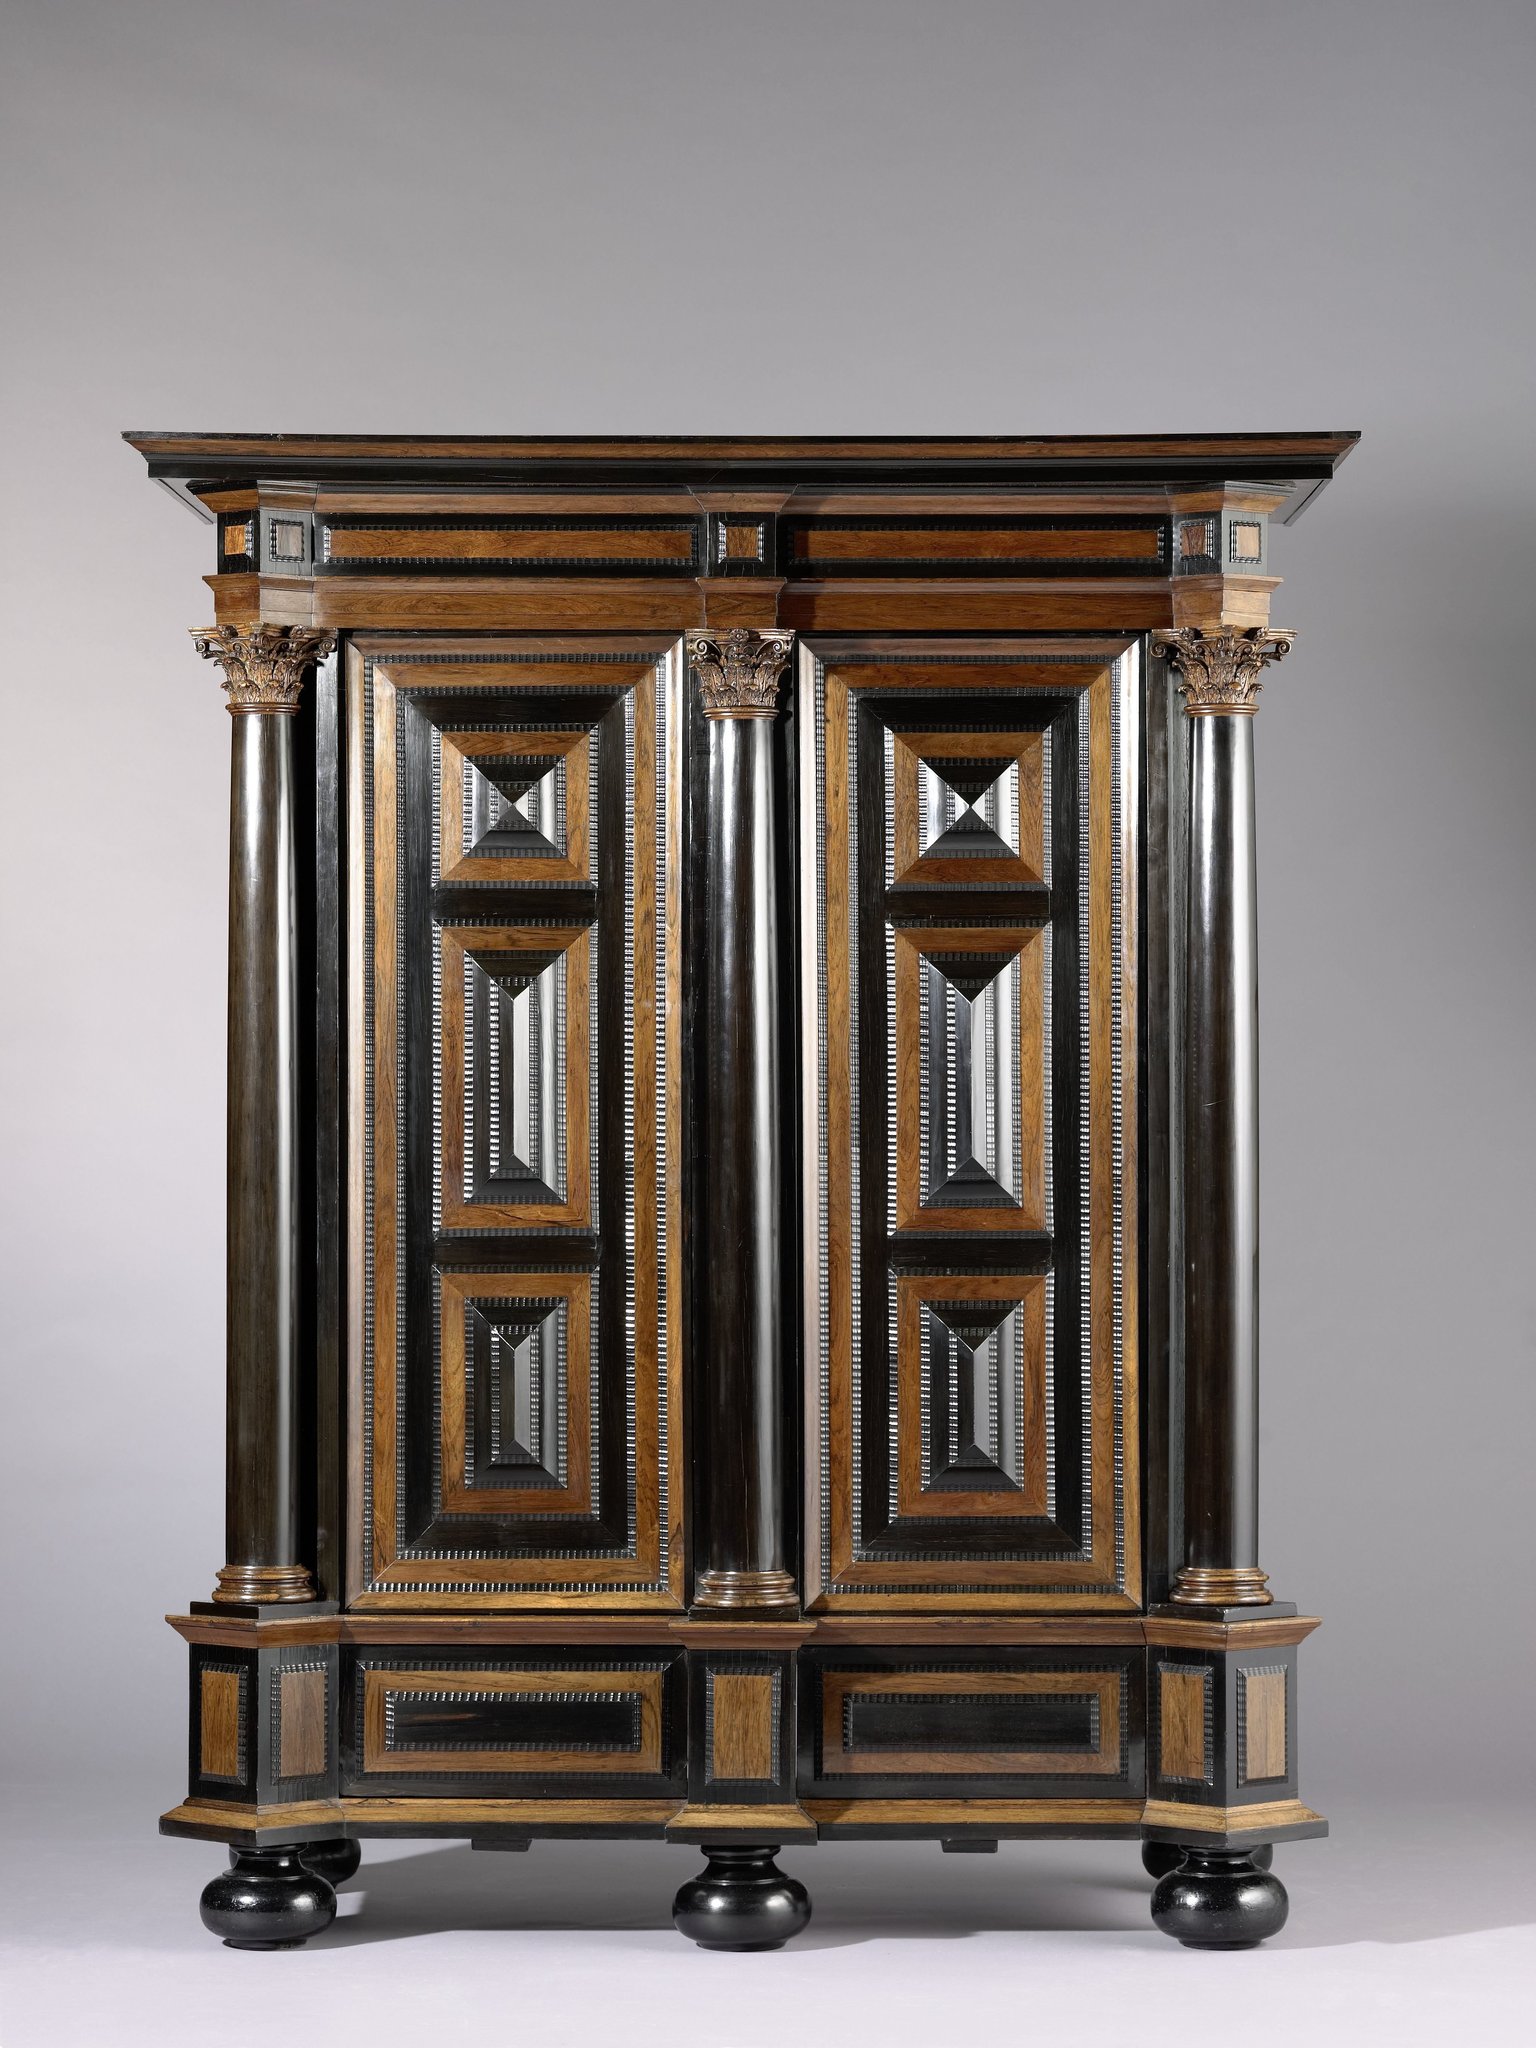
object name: case furniture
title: Cupboard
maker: Anonymous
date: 1650-1680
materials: wood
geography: netherlands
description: This cupboard is a sophisticated example of the art of the ebony worker, the furniture maker who veneered his work with precious exotic woods. The almost black ebony and the much lighter rosewood are used effectively, optimizing the contrast between their colours. The cupboard is primarily a work of art: its lock is hidden behind the central pilasters, and the drawers are without practical, but obtrusive knobs.